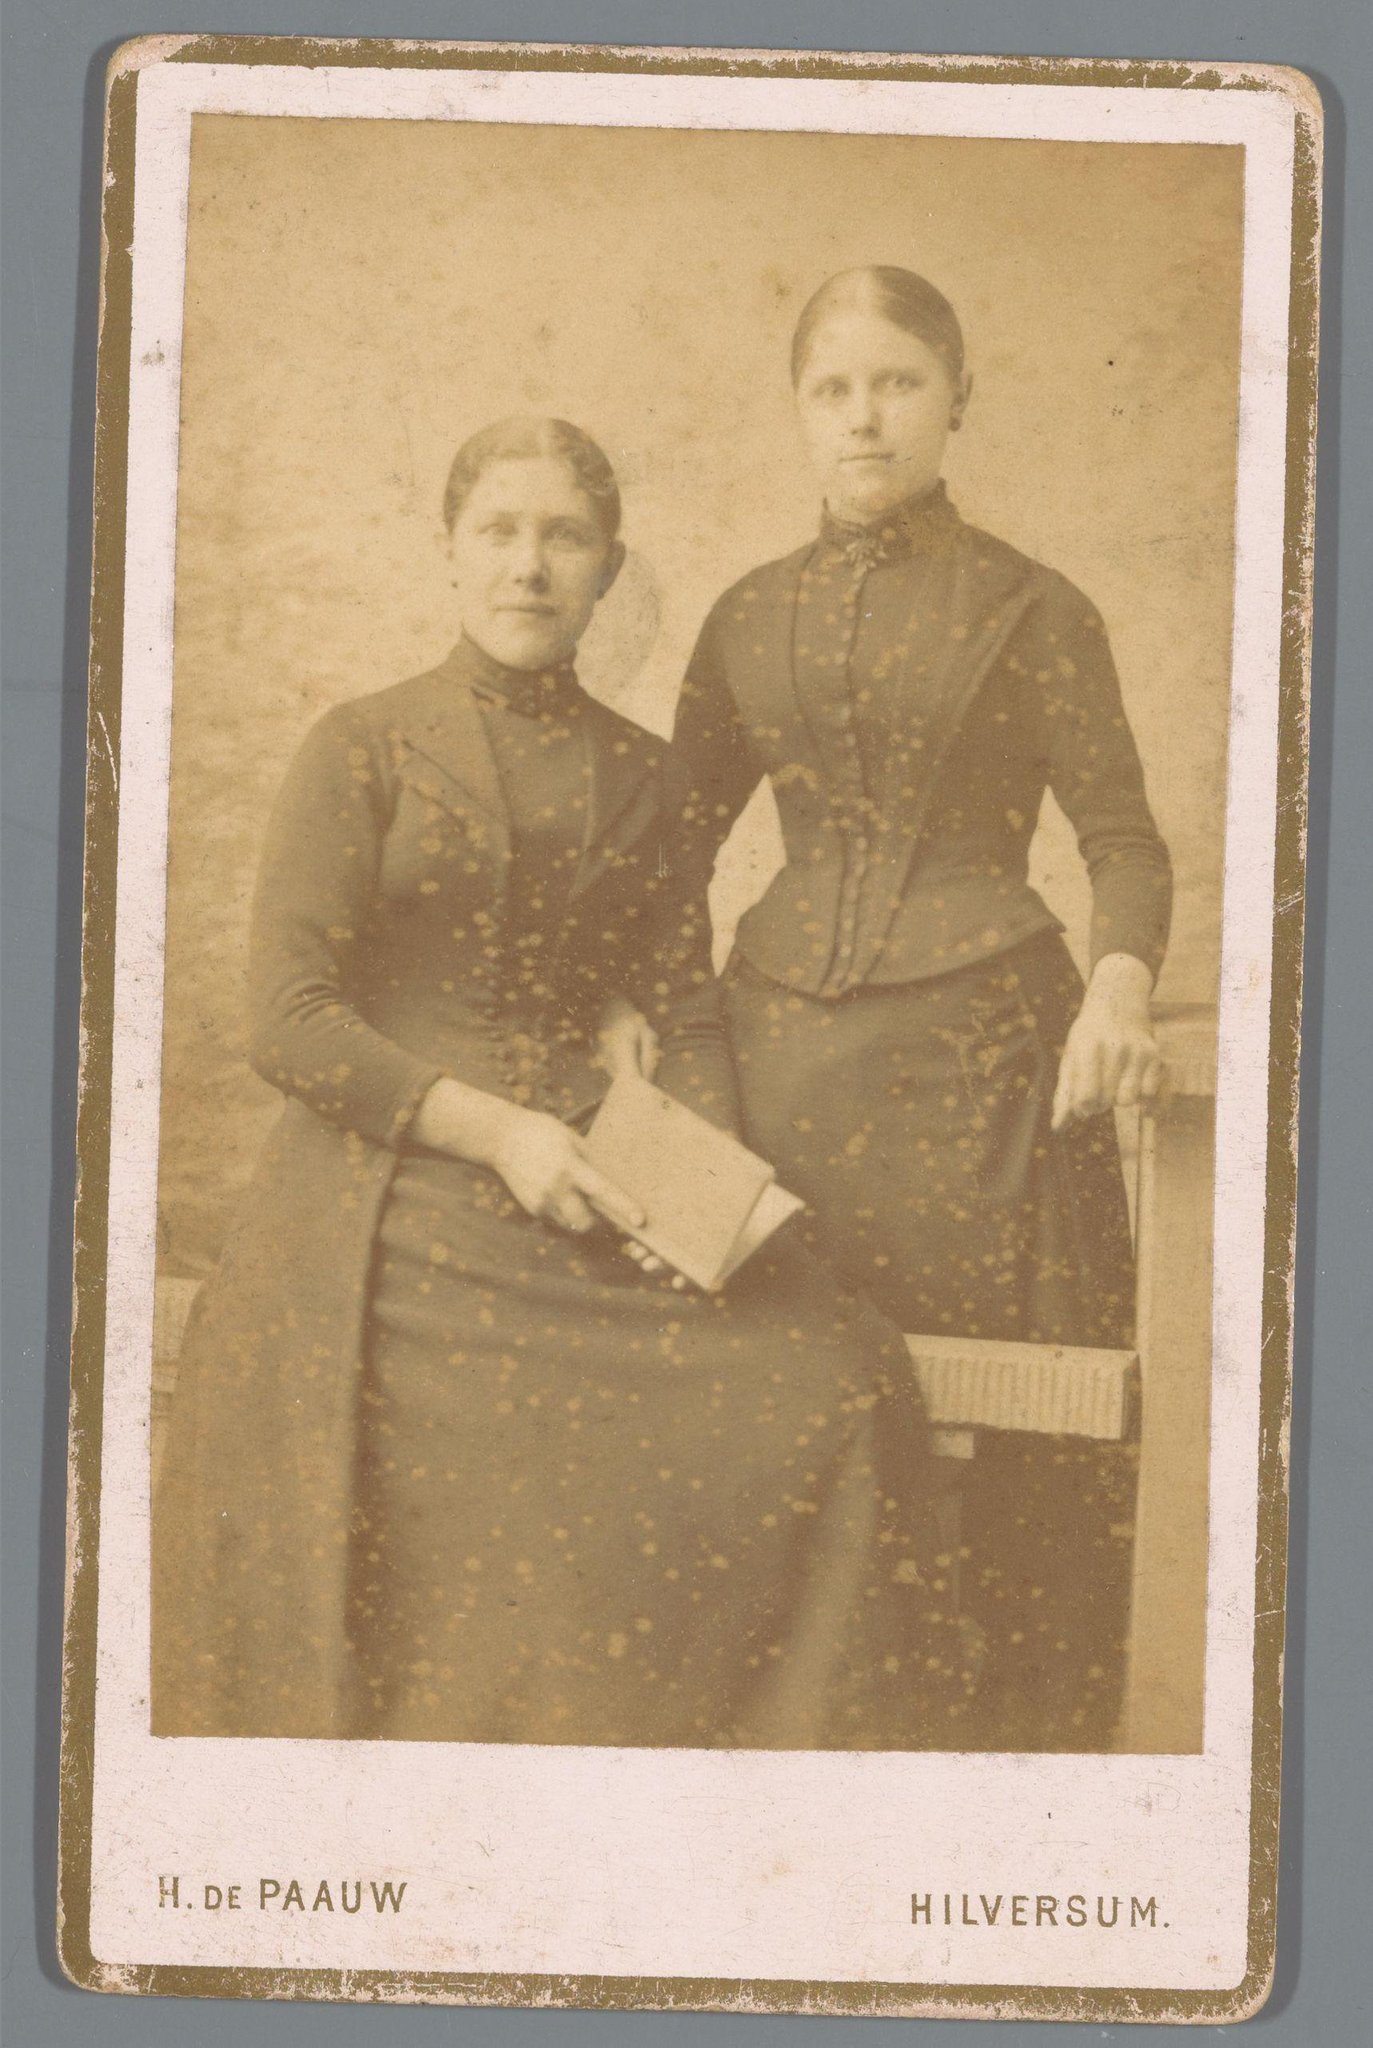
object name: photograph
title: Portret van twee onbekende vrouwen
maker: henri de paauw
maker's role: fotograaf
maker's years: 1849-1922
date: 1882-1903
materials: cardboard, paper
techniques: albumen print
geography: hilversum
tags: historical persons, adolescent, young woman, maiden (+ two persons)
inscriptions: inscription: ‘H. DE PAAUW/ Photogr. Atelier/ Instantanée/ HILVERSUM/ Kerkstraat/ 56/ De plaat blijft tot nabestelling bewaard.’